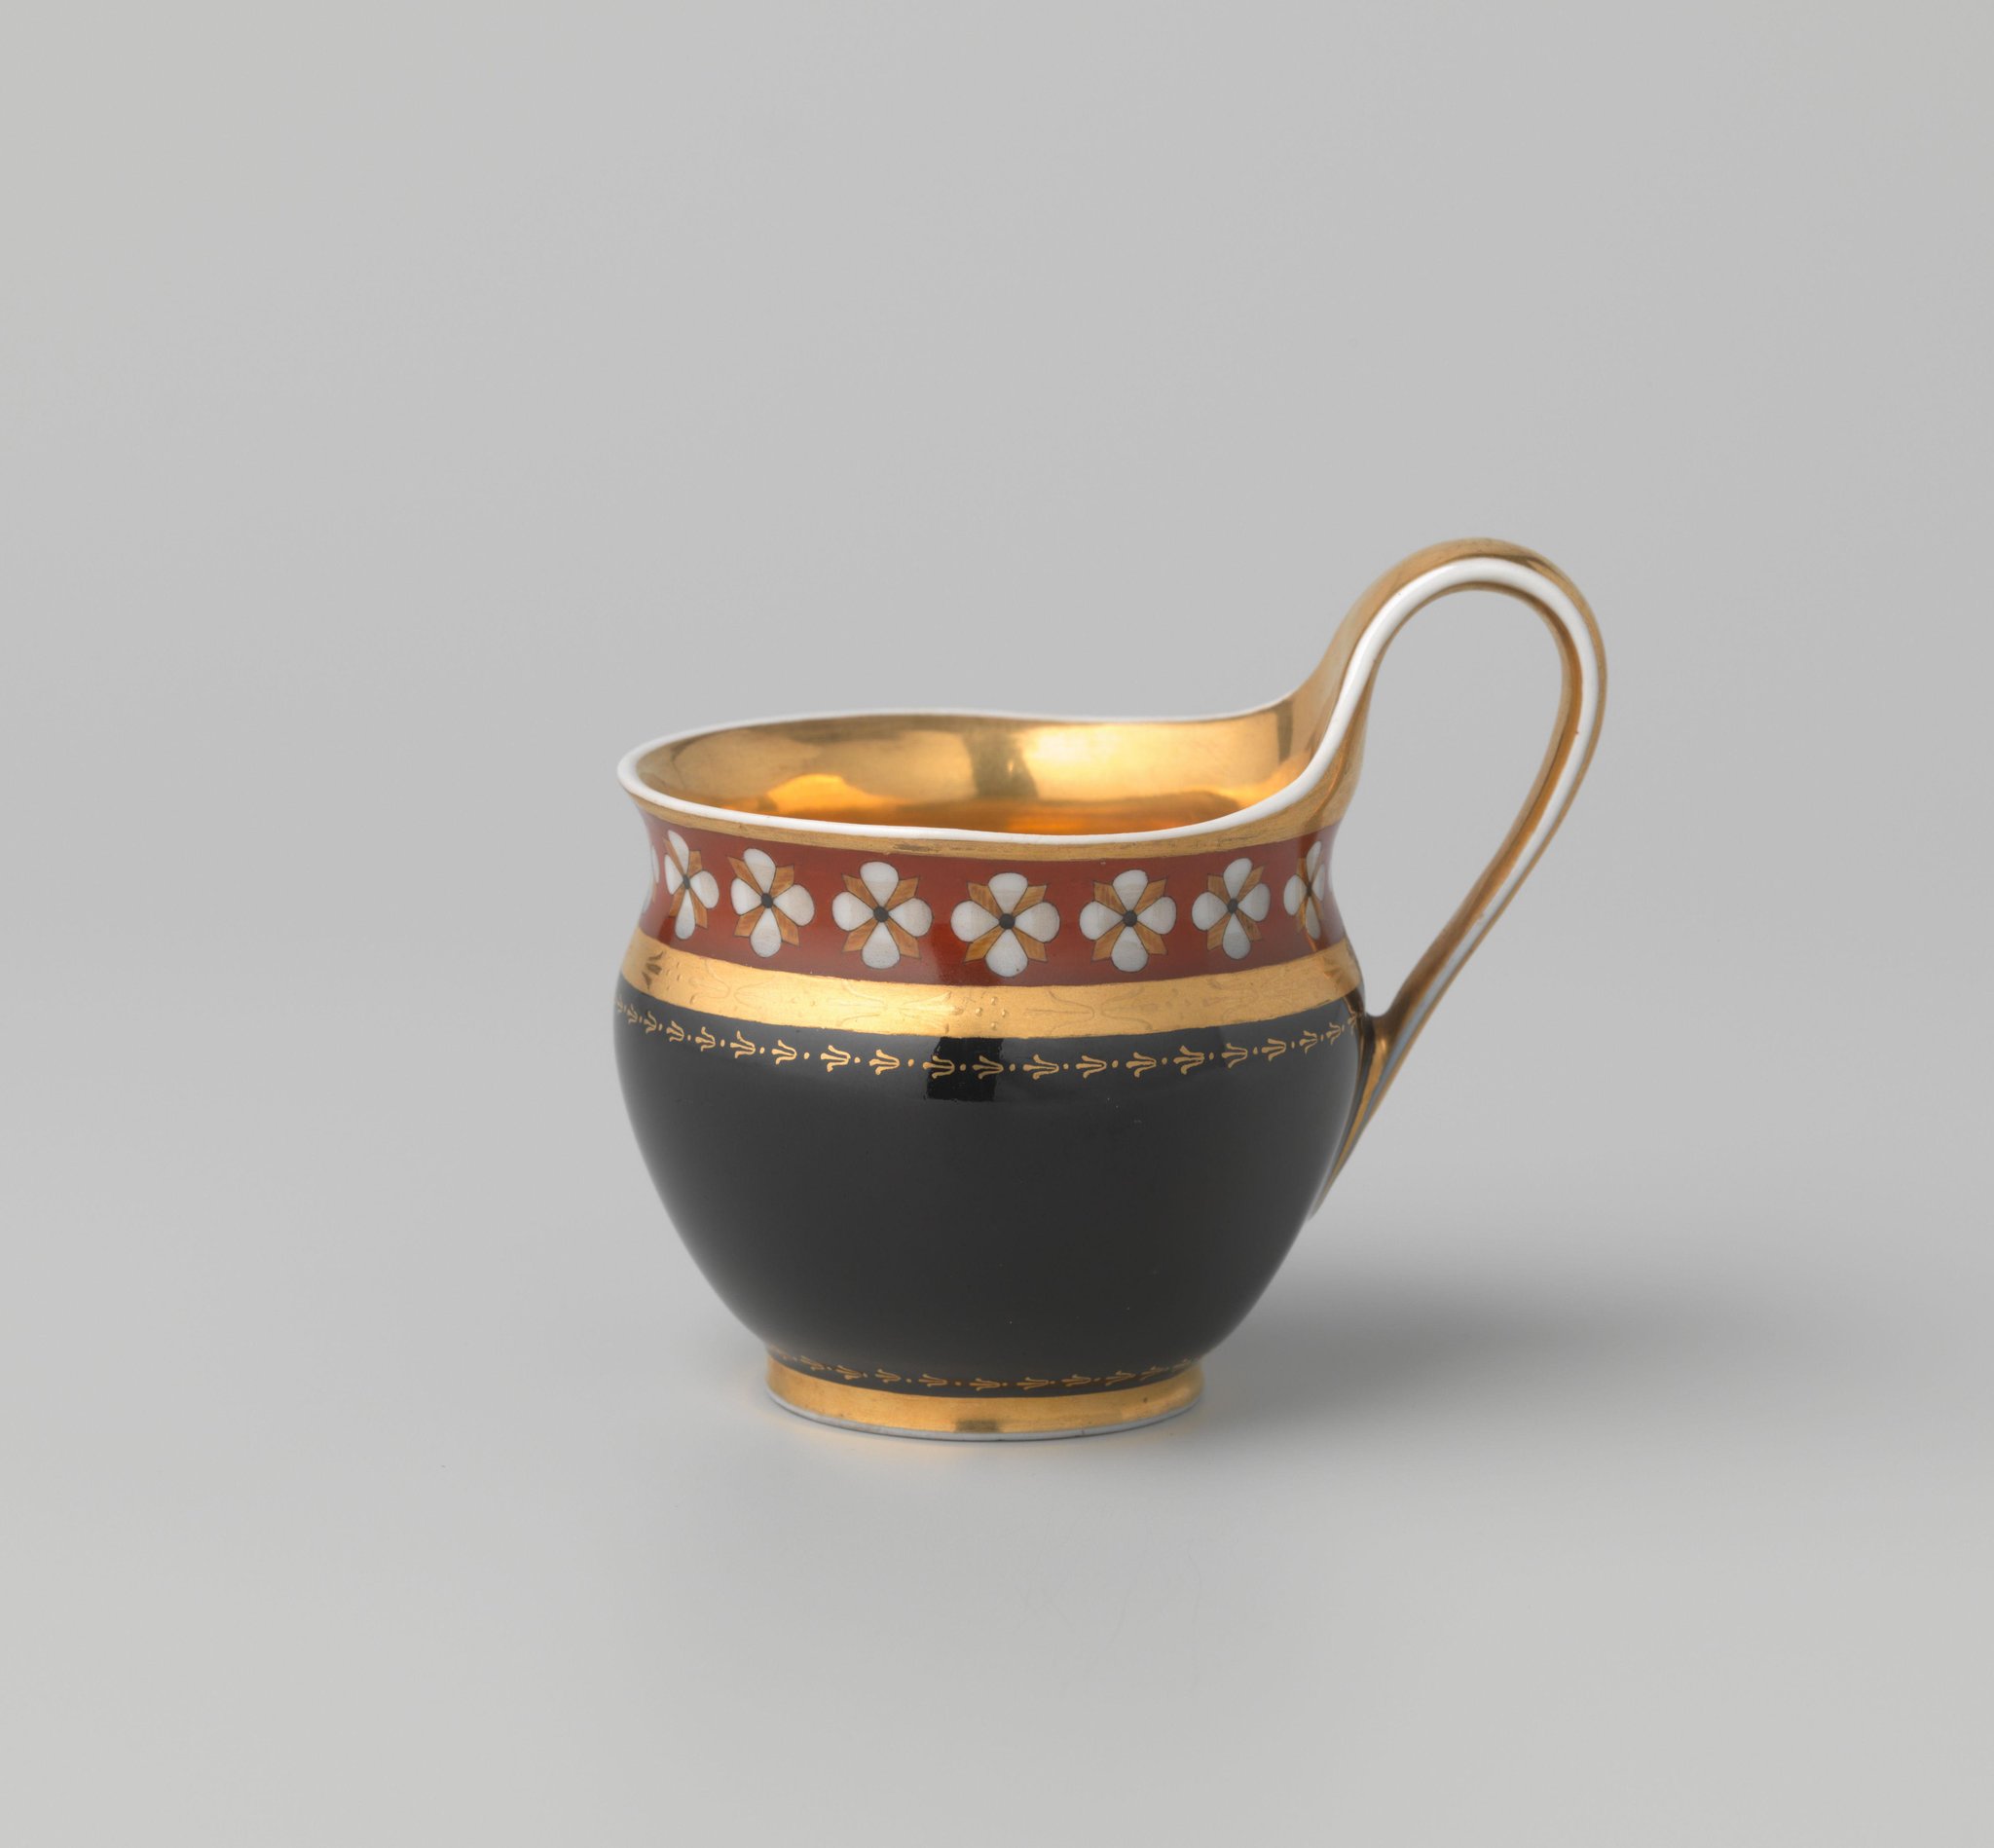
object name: cup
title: Cup with roundels and ornamental borders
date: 1870-1900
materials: glaze, gold, paint, porcelain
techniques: firing, forming, gilding, turning, vitrification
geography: berlin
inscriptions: mark: ‘scepter/ pijl of anker/ 33/ I’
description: Kop van porselein met een bolvormige buik en iets spreidende rand, beschilderd in onderglazuur blauw en op het glazuur rood, geel, zwart en goud. C-vormig oor vanuit de rand. De buitenrand met een band rozetten uitgespaard in rood. De buik is bedekt met blauw met decoratieve banden in goud. De binnnenzijde en oor zijn bedekt met goud. Gemerkt op de onderzijde met de scepter, een gouden pijl of anker, het nummer 33 en I.